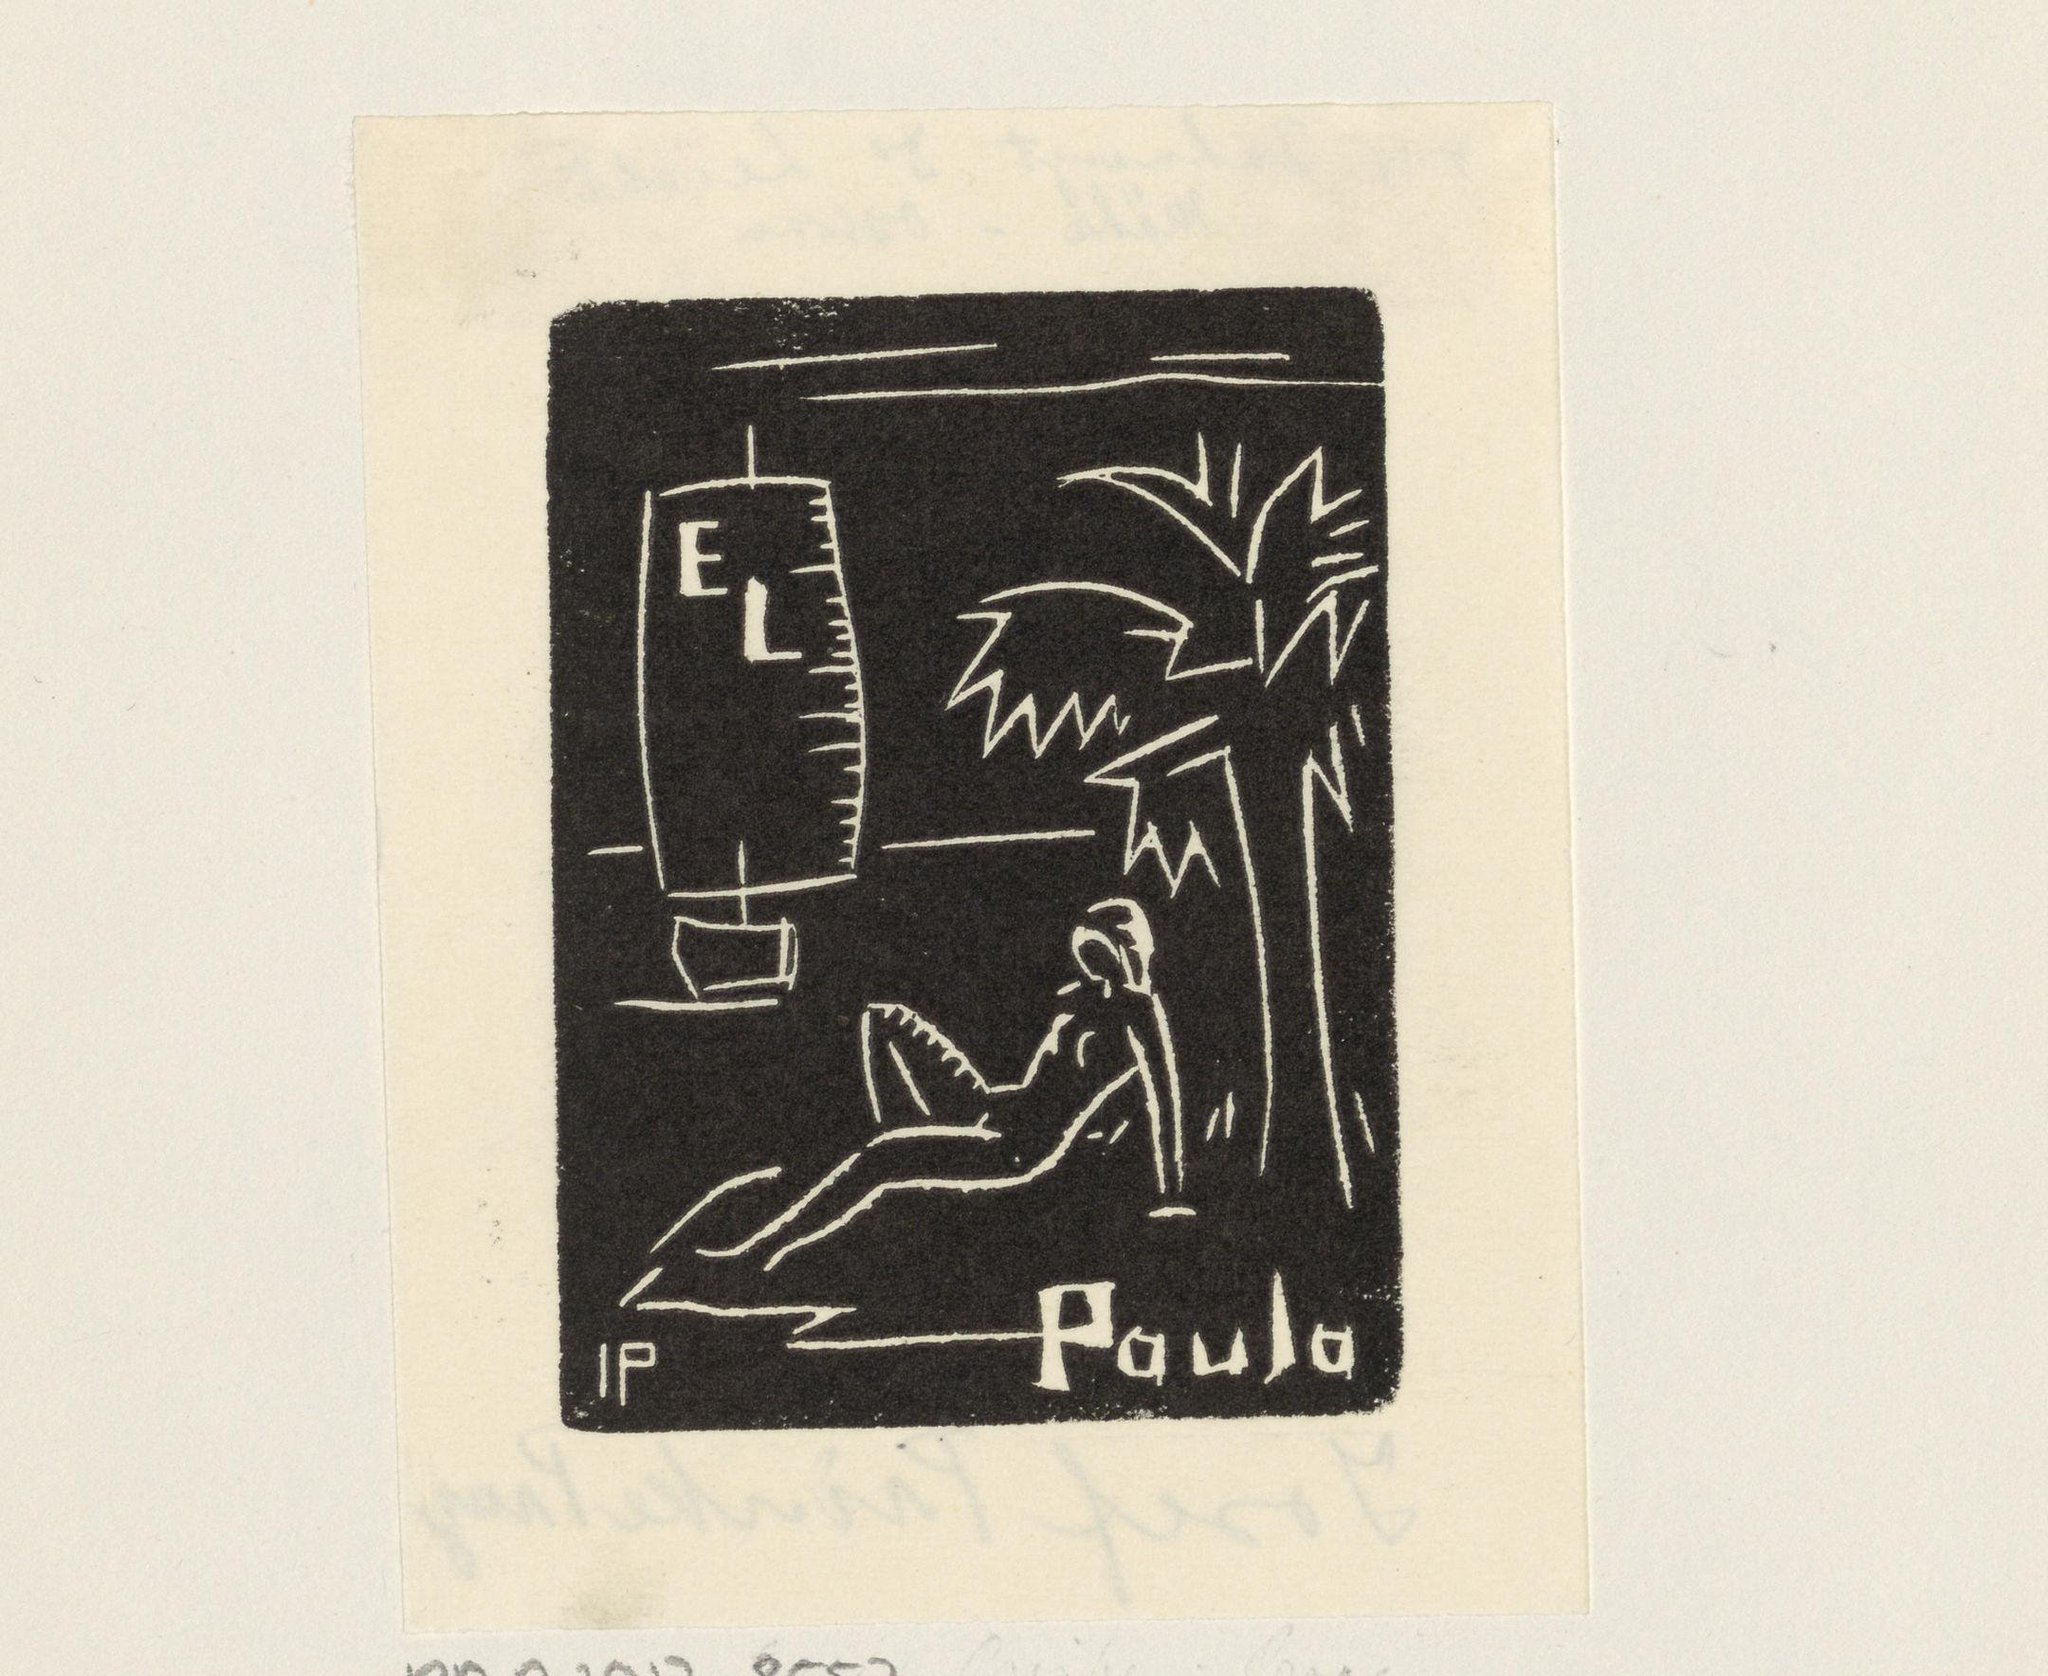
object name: bookplate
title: EL Paula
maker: josef prinke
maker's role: print maker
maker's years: 1891-1945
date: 1901-1945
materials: paper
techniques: linocut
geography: czech republic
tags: sailing-ship, sailing-boat, woman (showing herself) undressed, quasi-nude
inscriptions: inscription: ‘Voor: Zahnartzt Dr. Leicht - Mühr Ostrau [?]’